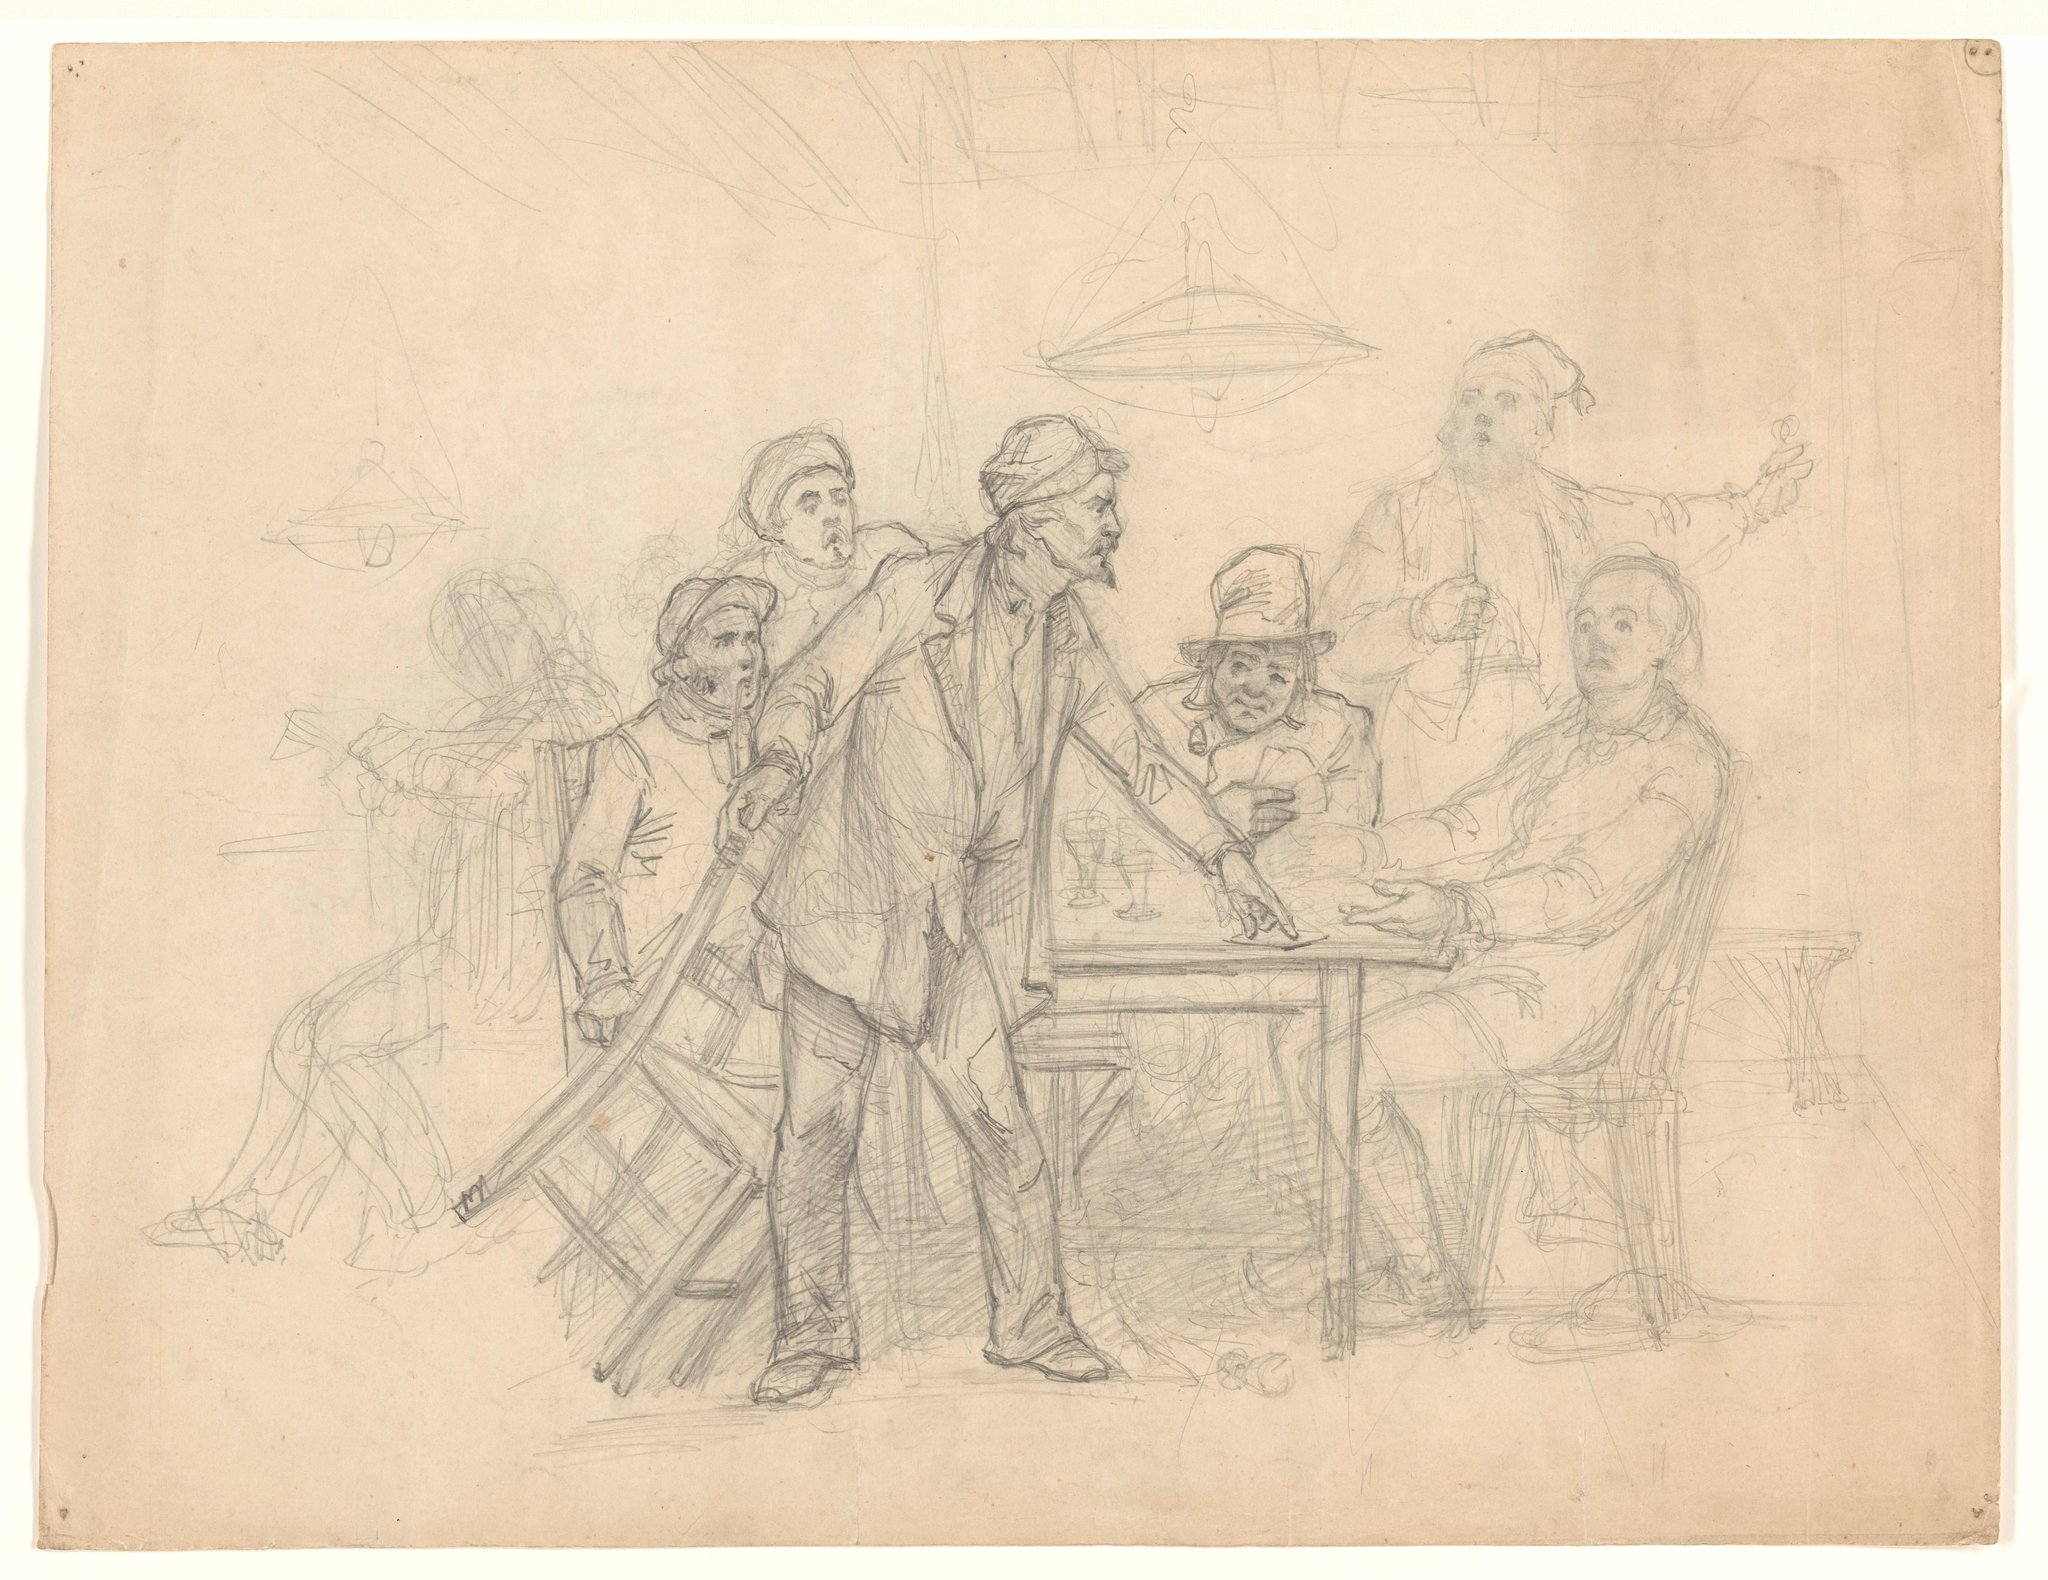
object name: design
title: Ruzie tussen mannen rond een tafel in een café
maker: johan braakensiek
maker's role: draughtsman, print maker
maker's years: 1858-1940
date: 1868-1940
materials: paper, pencil